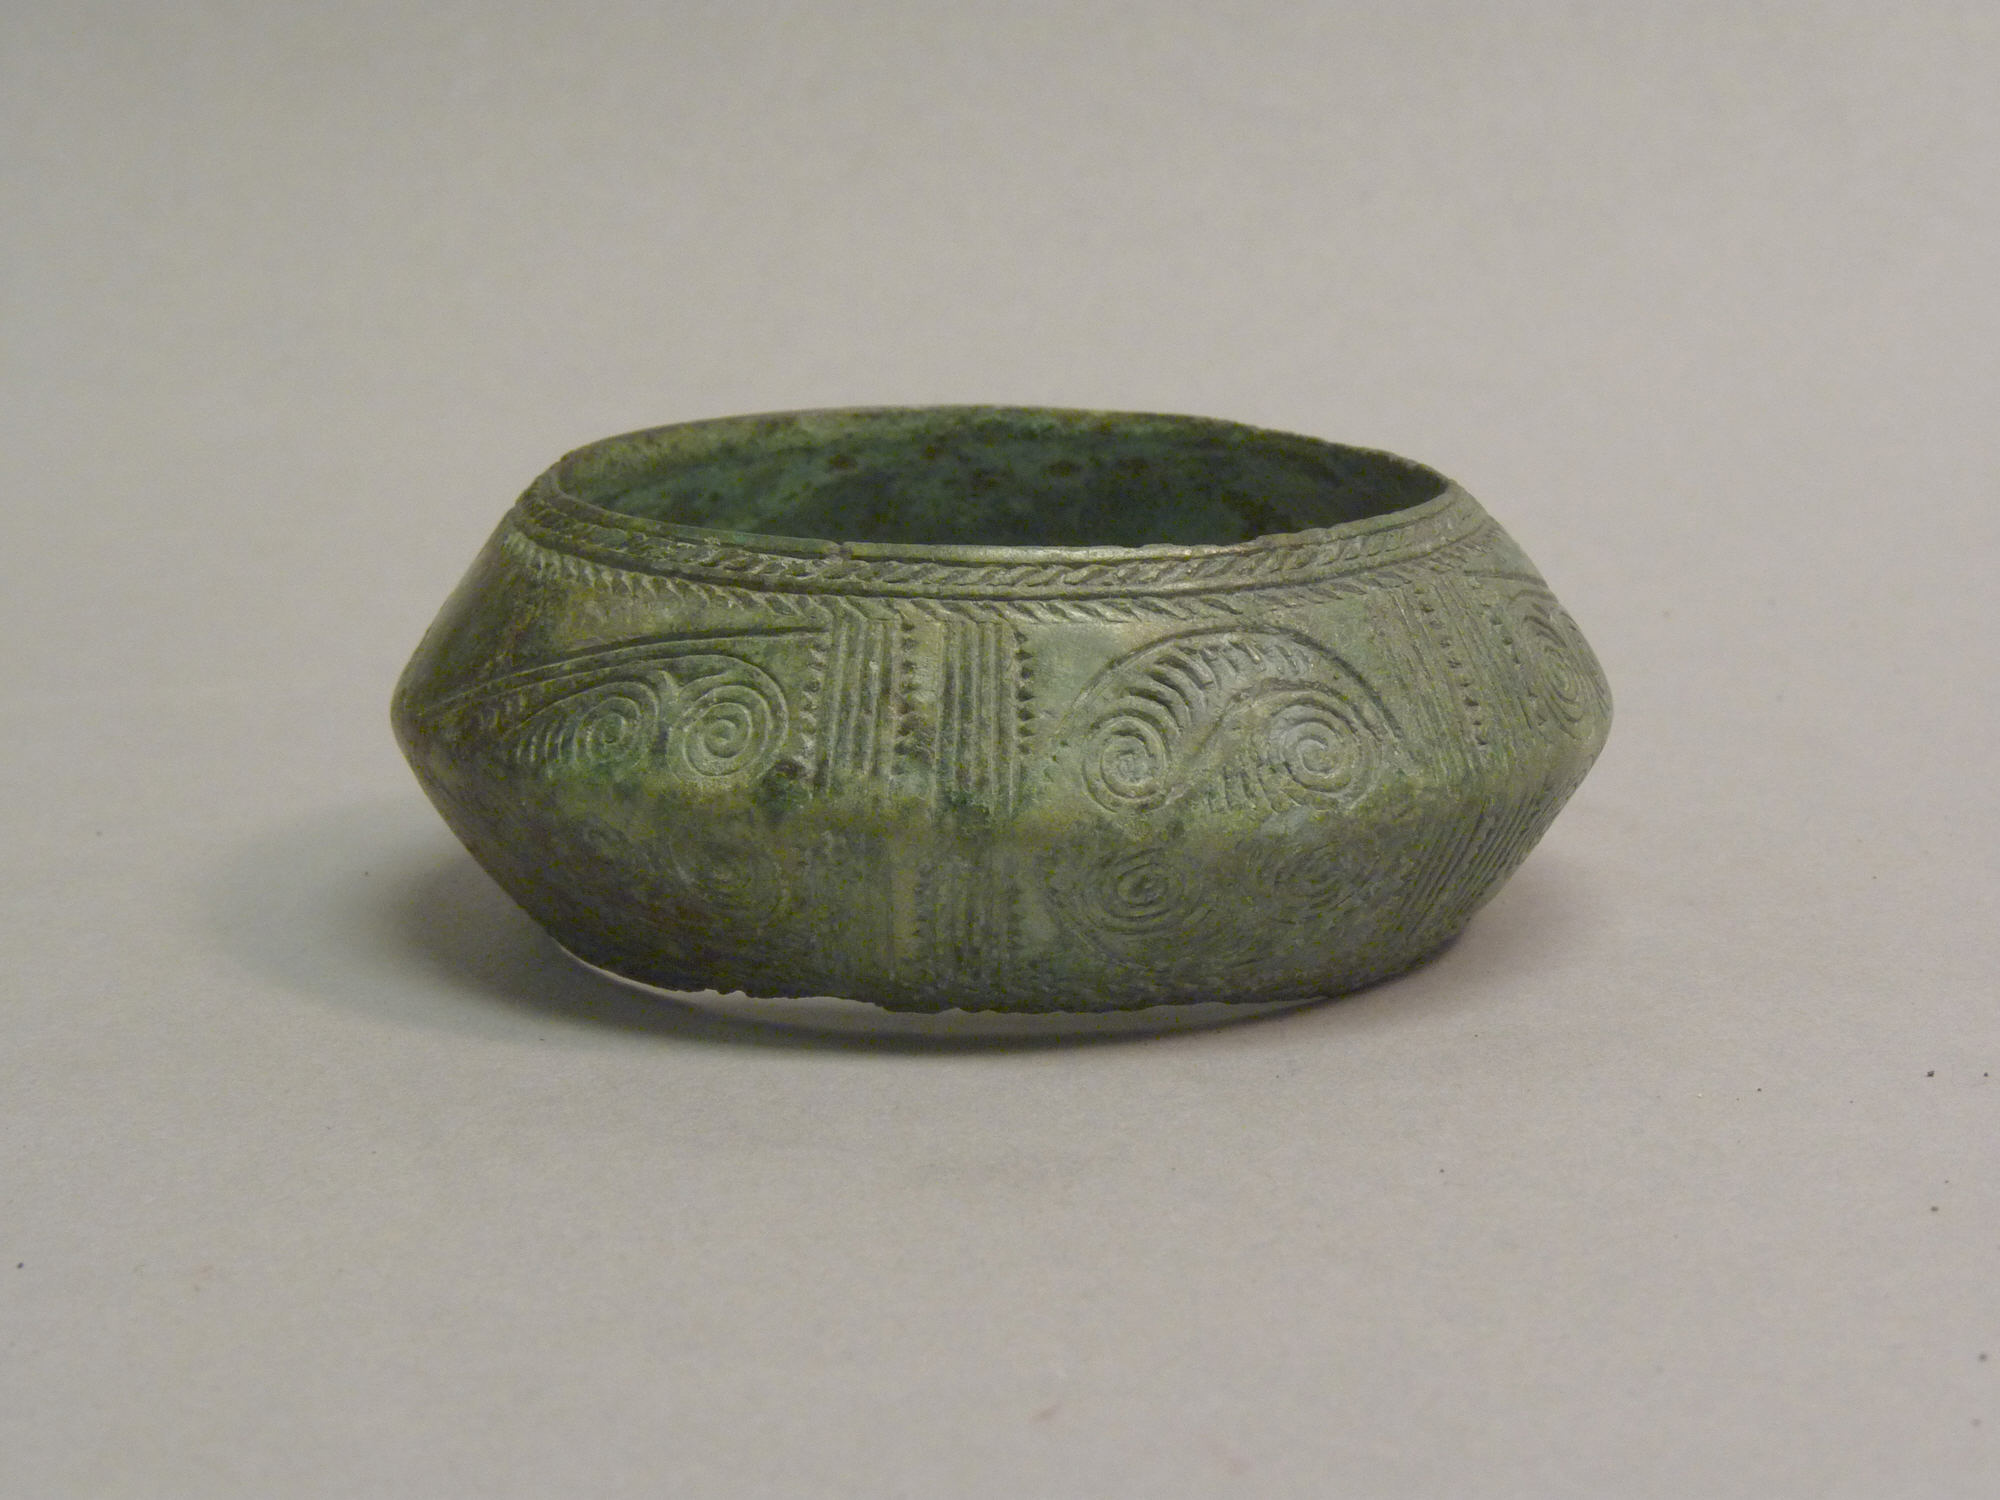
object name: bracelet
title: Bracelet with Flared Profile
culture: thai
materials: bronze